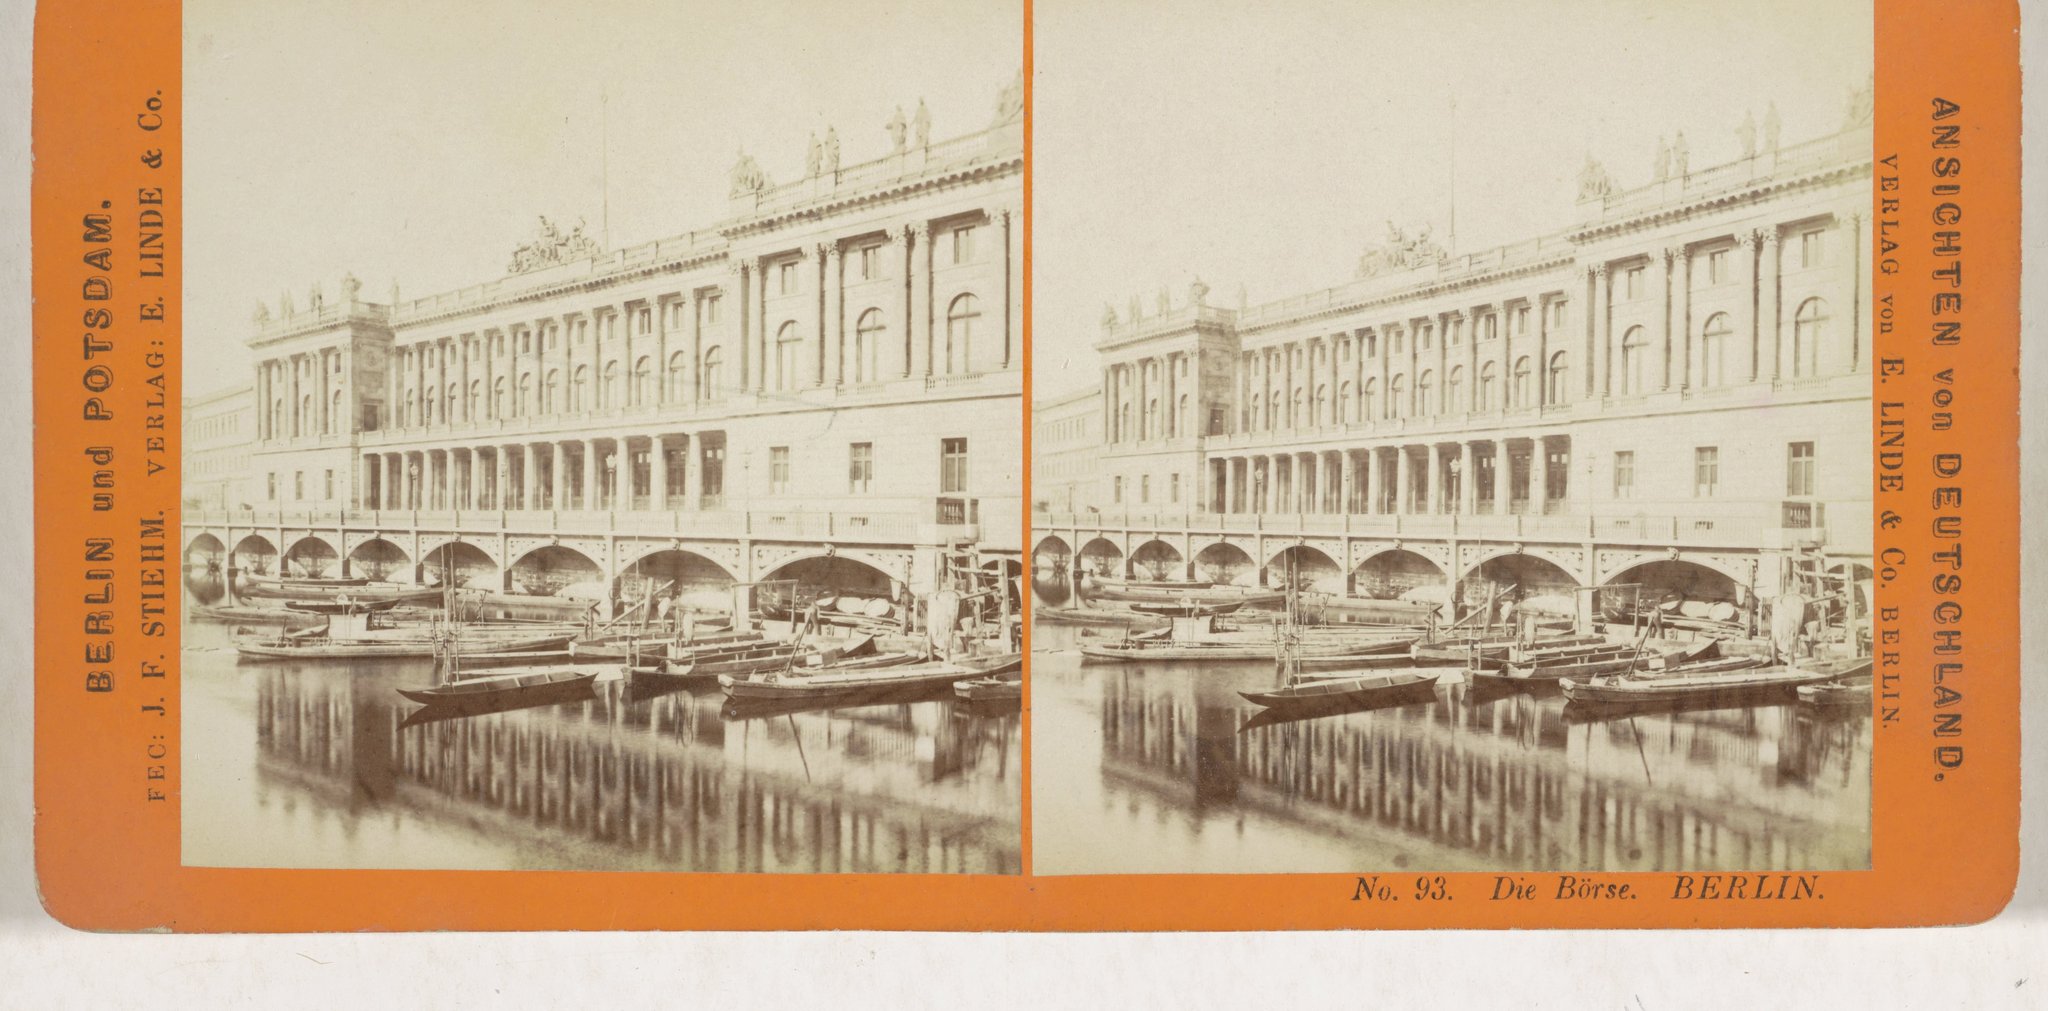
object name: stereograph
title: Die Börse. Berlin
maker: johann friedrich stiehm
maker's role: fotograaf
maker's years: 1826-1902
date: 1868-1870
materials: cardboard, paper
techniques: albumen print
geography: berlin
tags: stock exchange, stock-market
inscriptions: number: ‘No. 93.’